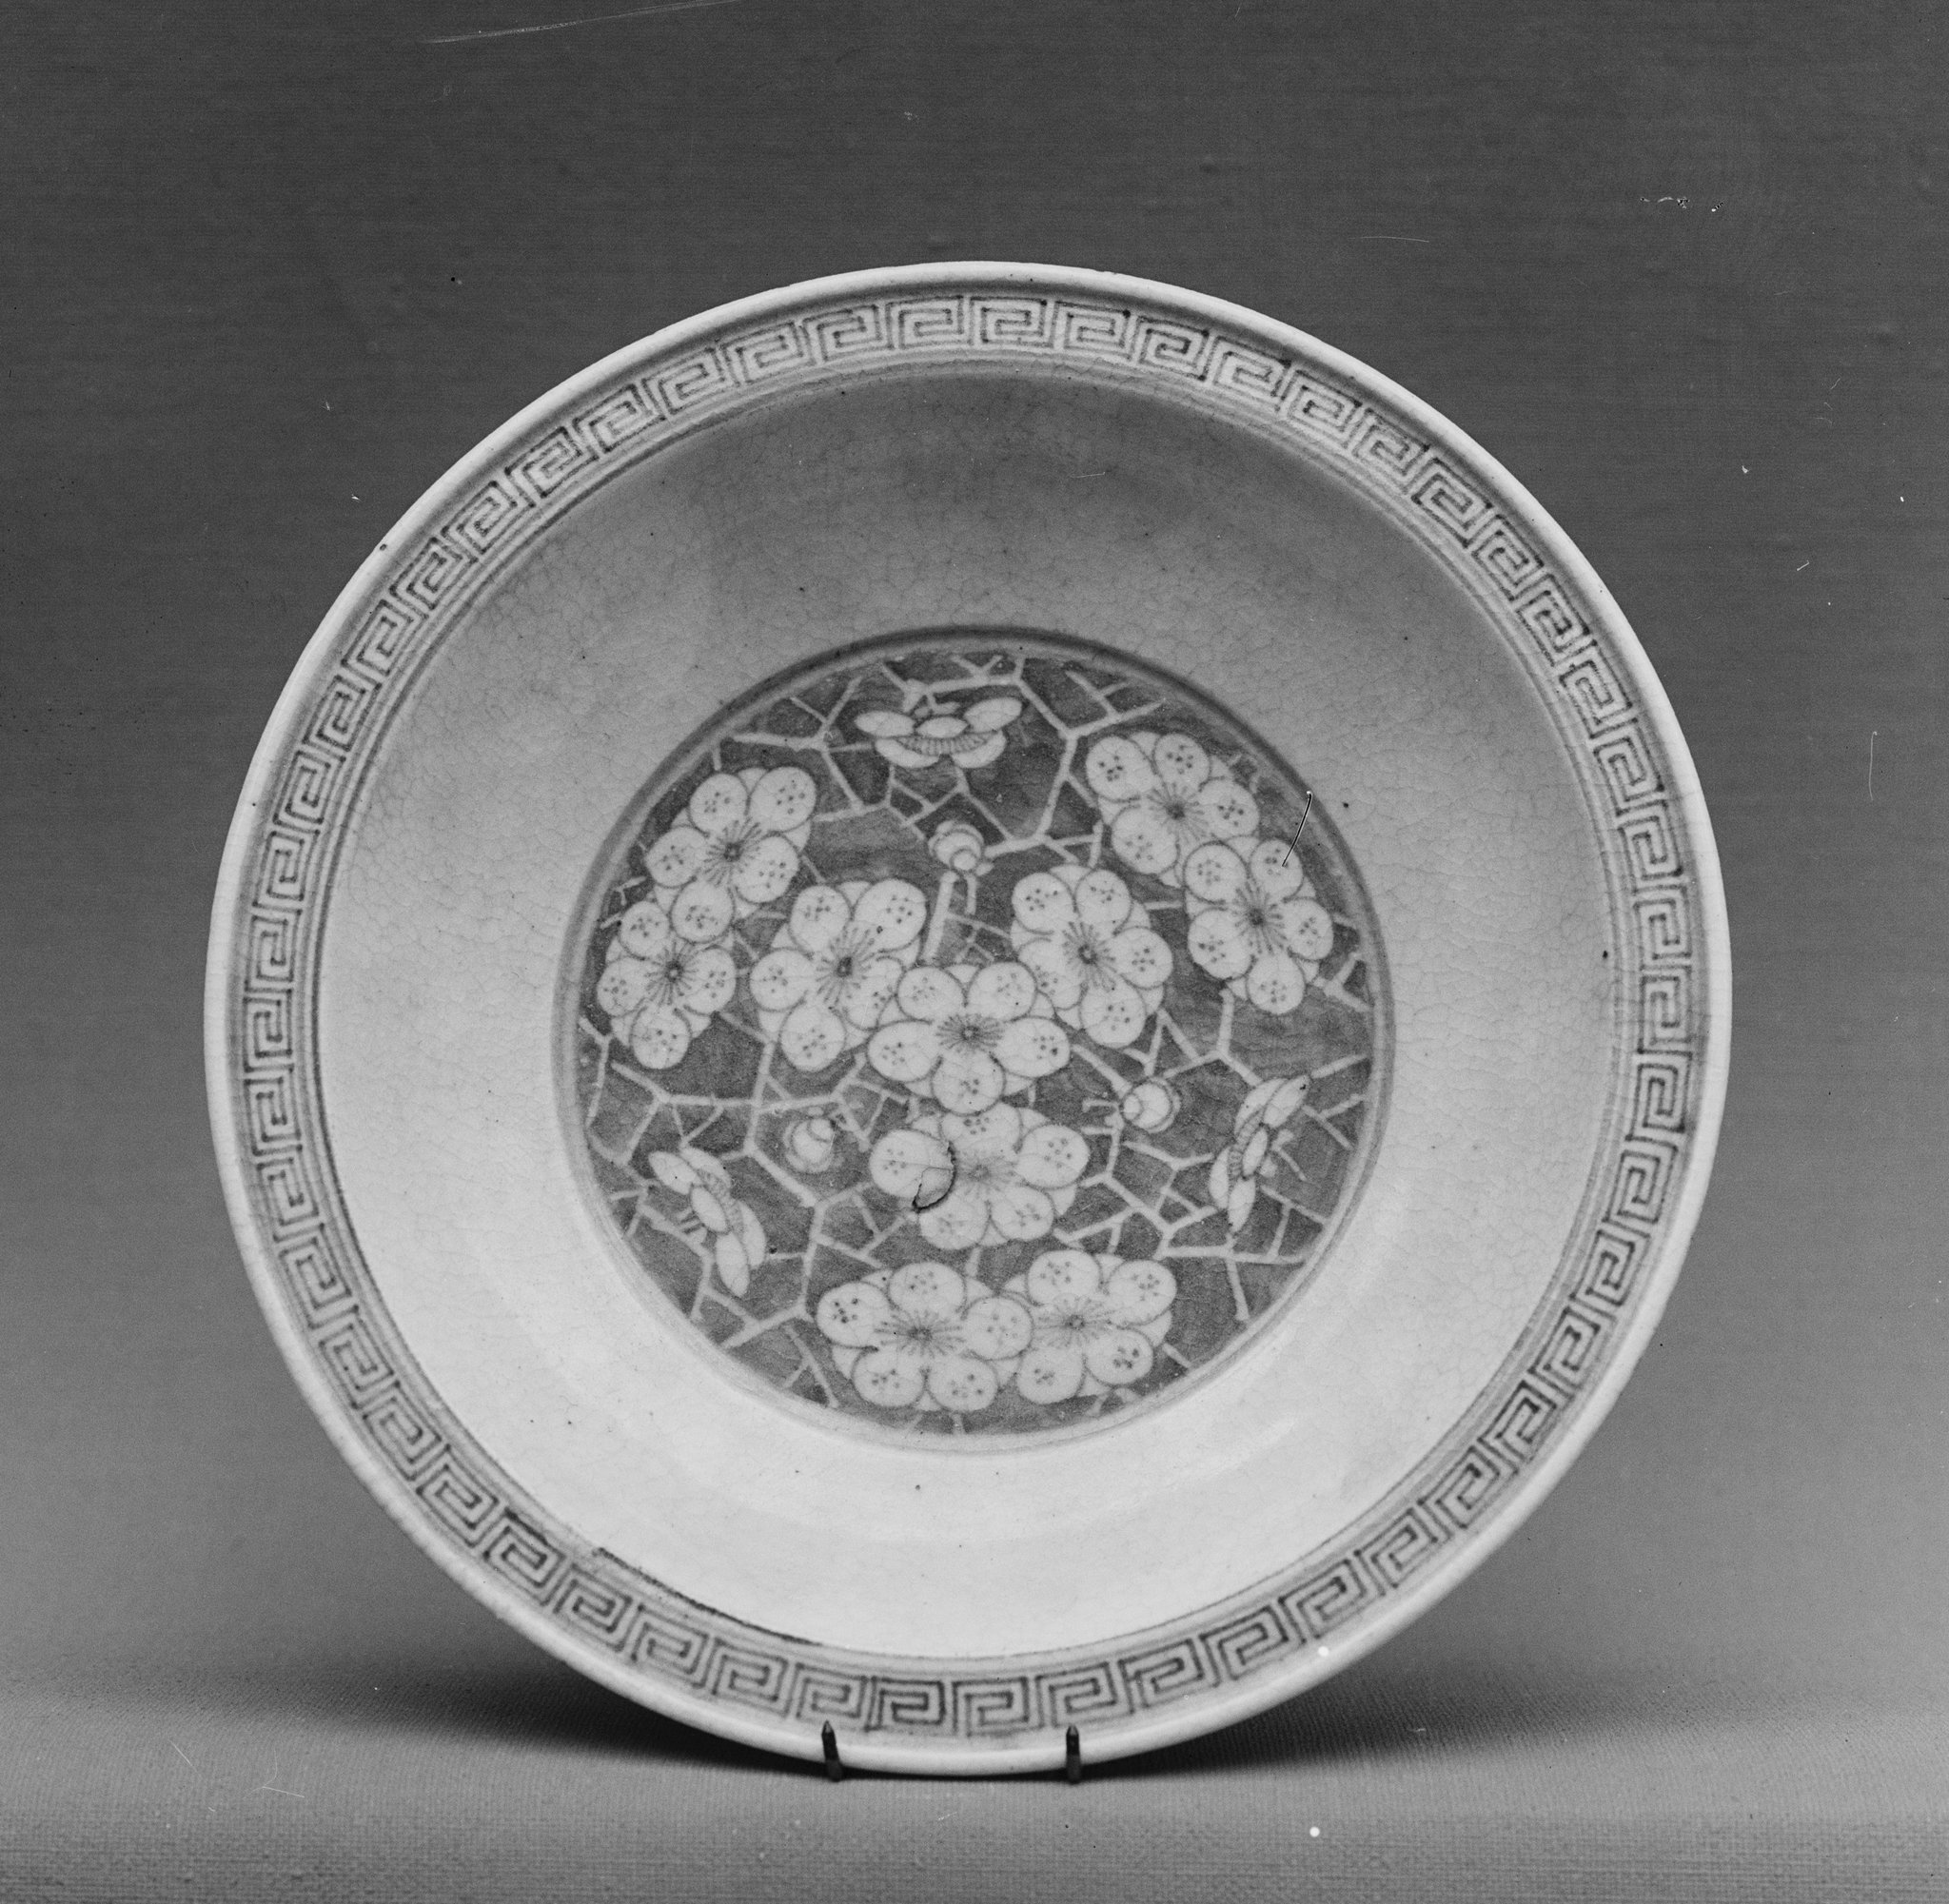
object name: saucer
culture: japanese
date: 1820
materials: clay, glaze